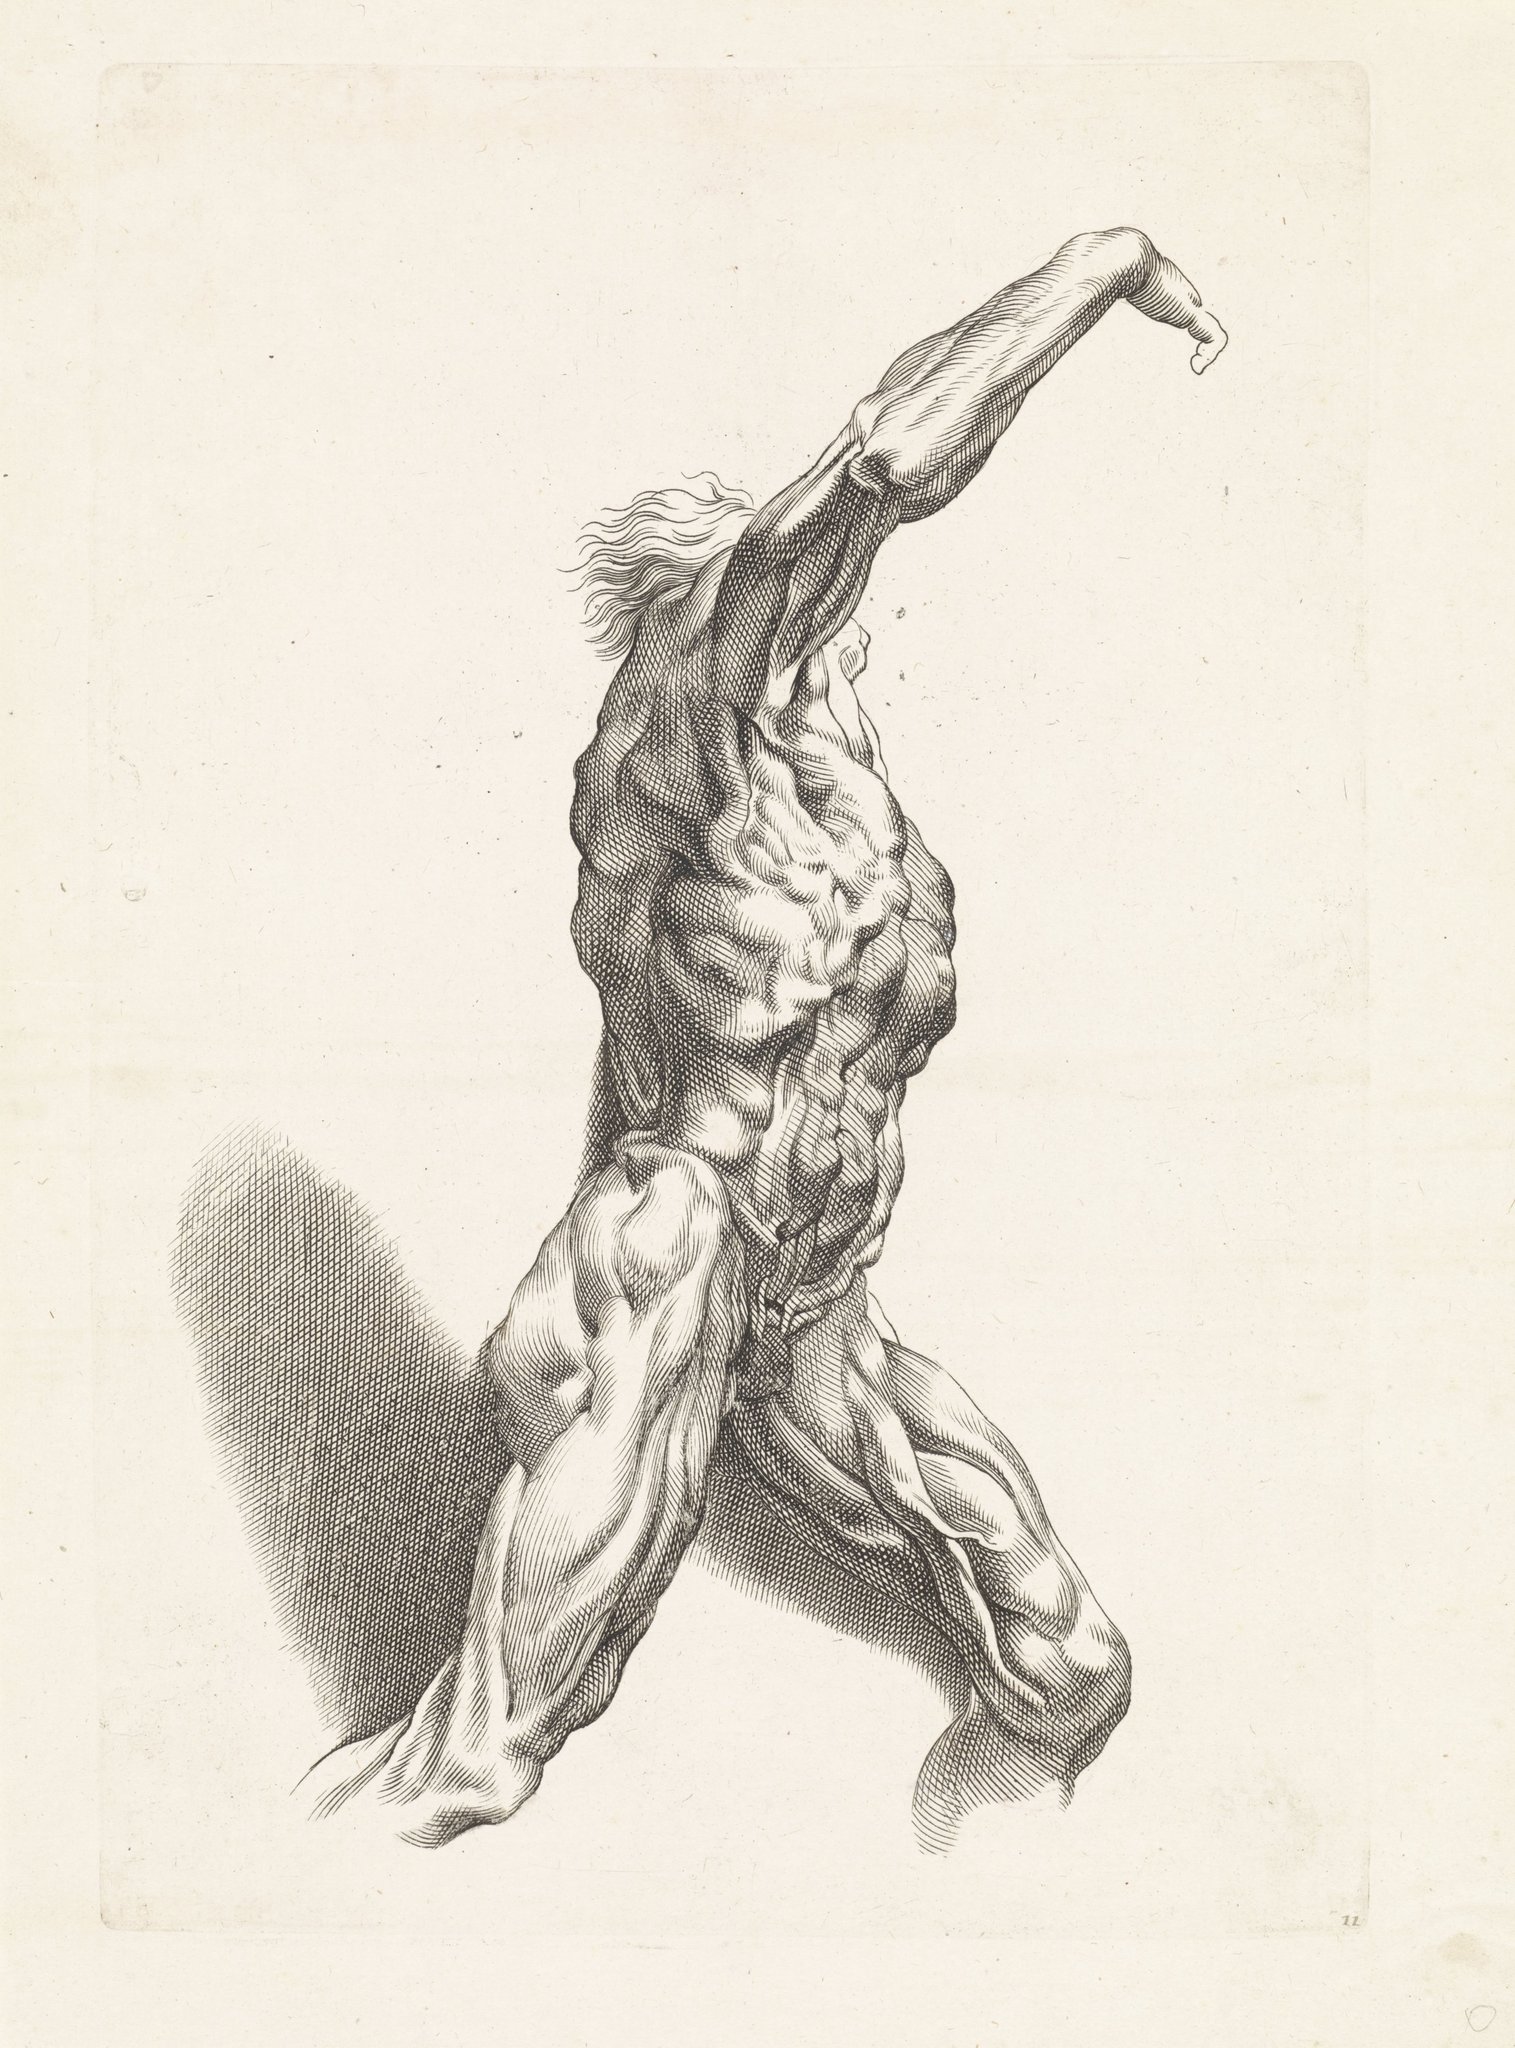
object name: print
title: Anatomische studie van een man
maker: paulus pontius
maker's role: draughtsman, print maker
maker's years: 1603-1658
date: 1616-1657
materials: paper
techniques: engraving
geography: antwerp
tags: parts of the human body (skeleton excepted)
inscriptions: number: ‘11’, collector's mark: Lugt 240